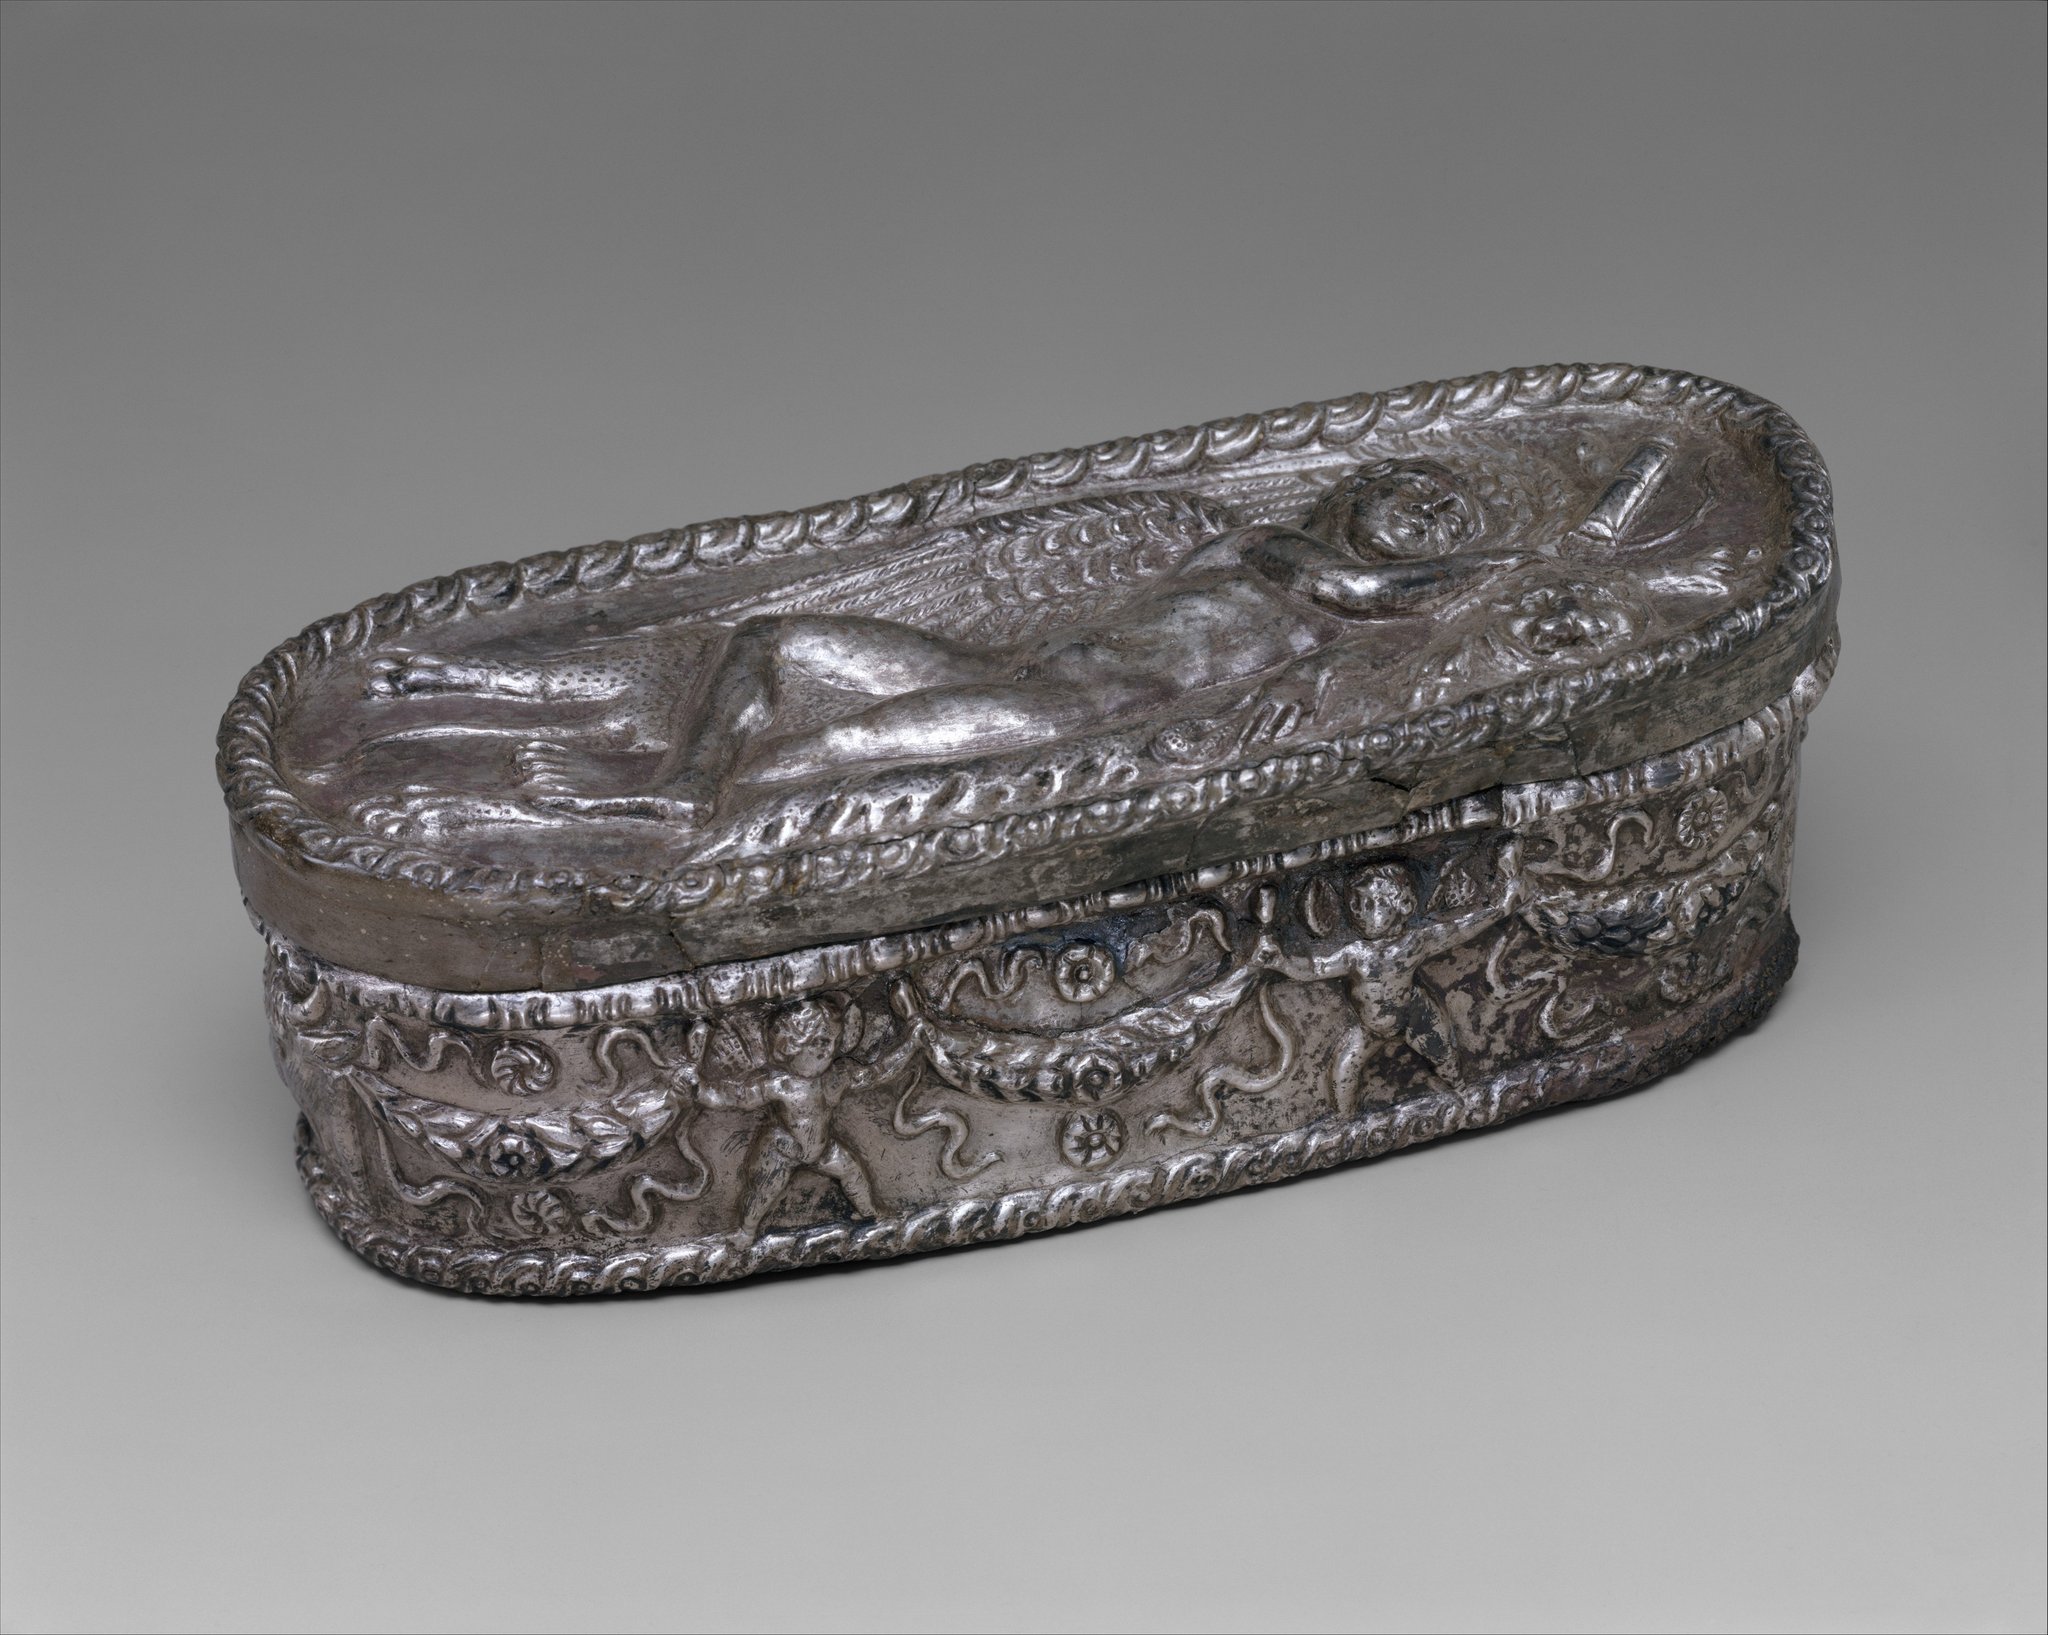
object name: box with cover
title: Box with Sleeping Eros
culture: byzantine or roman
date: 300-400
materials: silver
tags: eros,putti,bulls